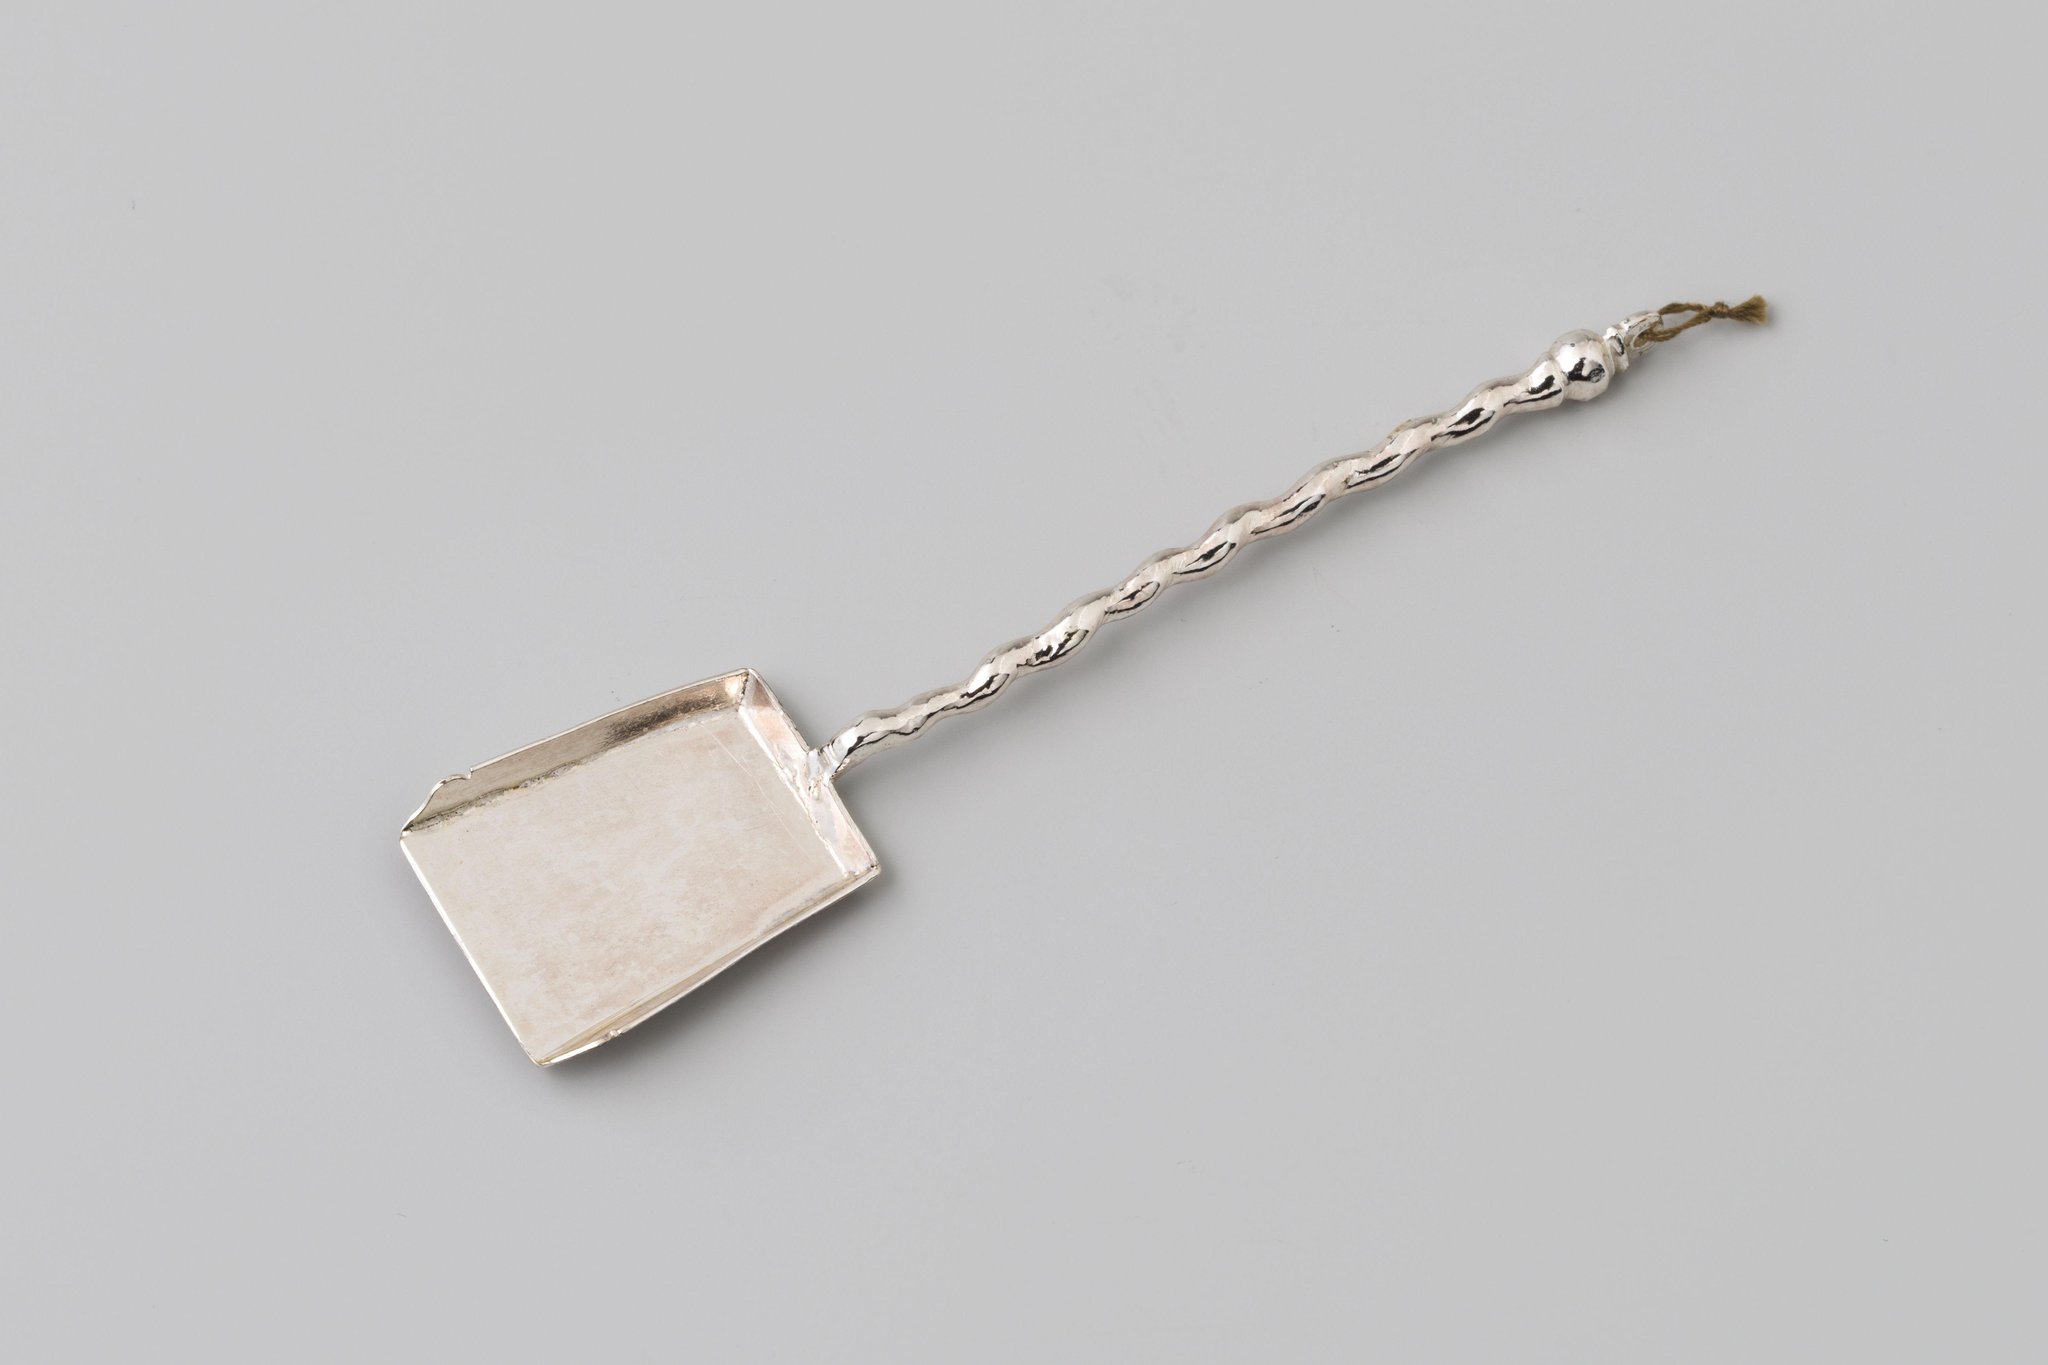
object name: ash shovel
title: Asschop van zilver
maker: Anonymous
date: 1675-1700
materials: silver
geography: amsterdam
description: Asschop van zilver, met getorste steel met knop. Bak onversierd; kleine inkeping in rand van de bak.